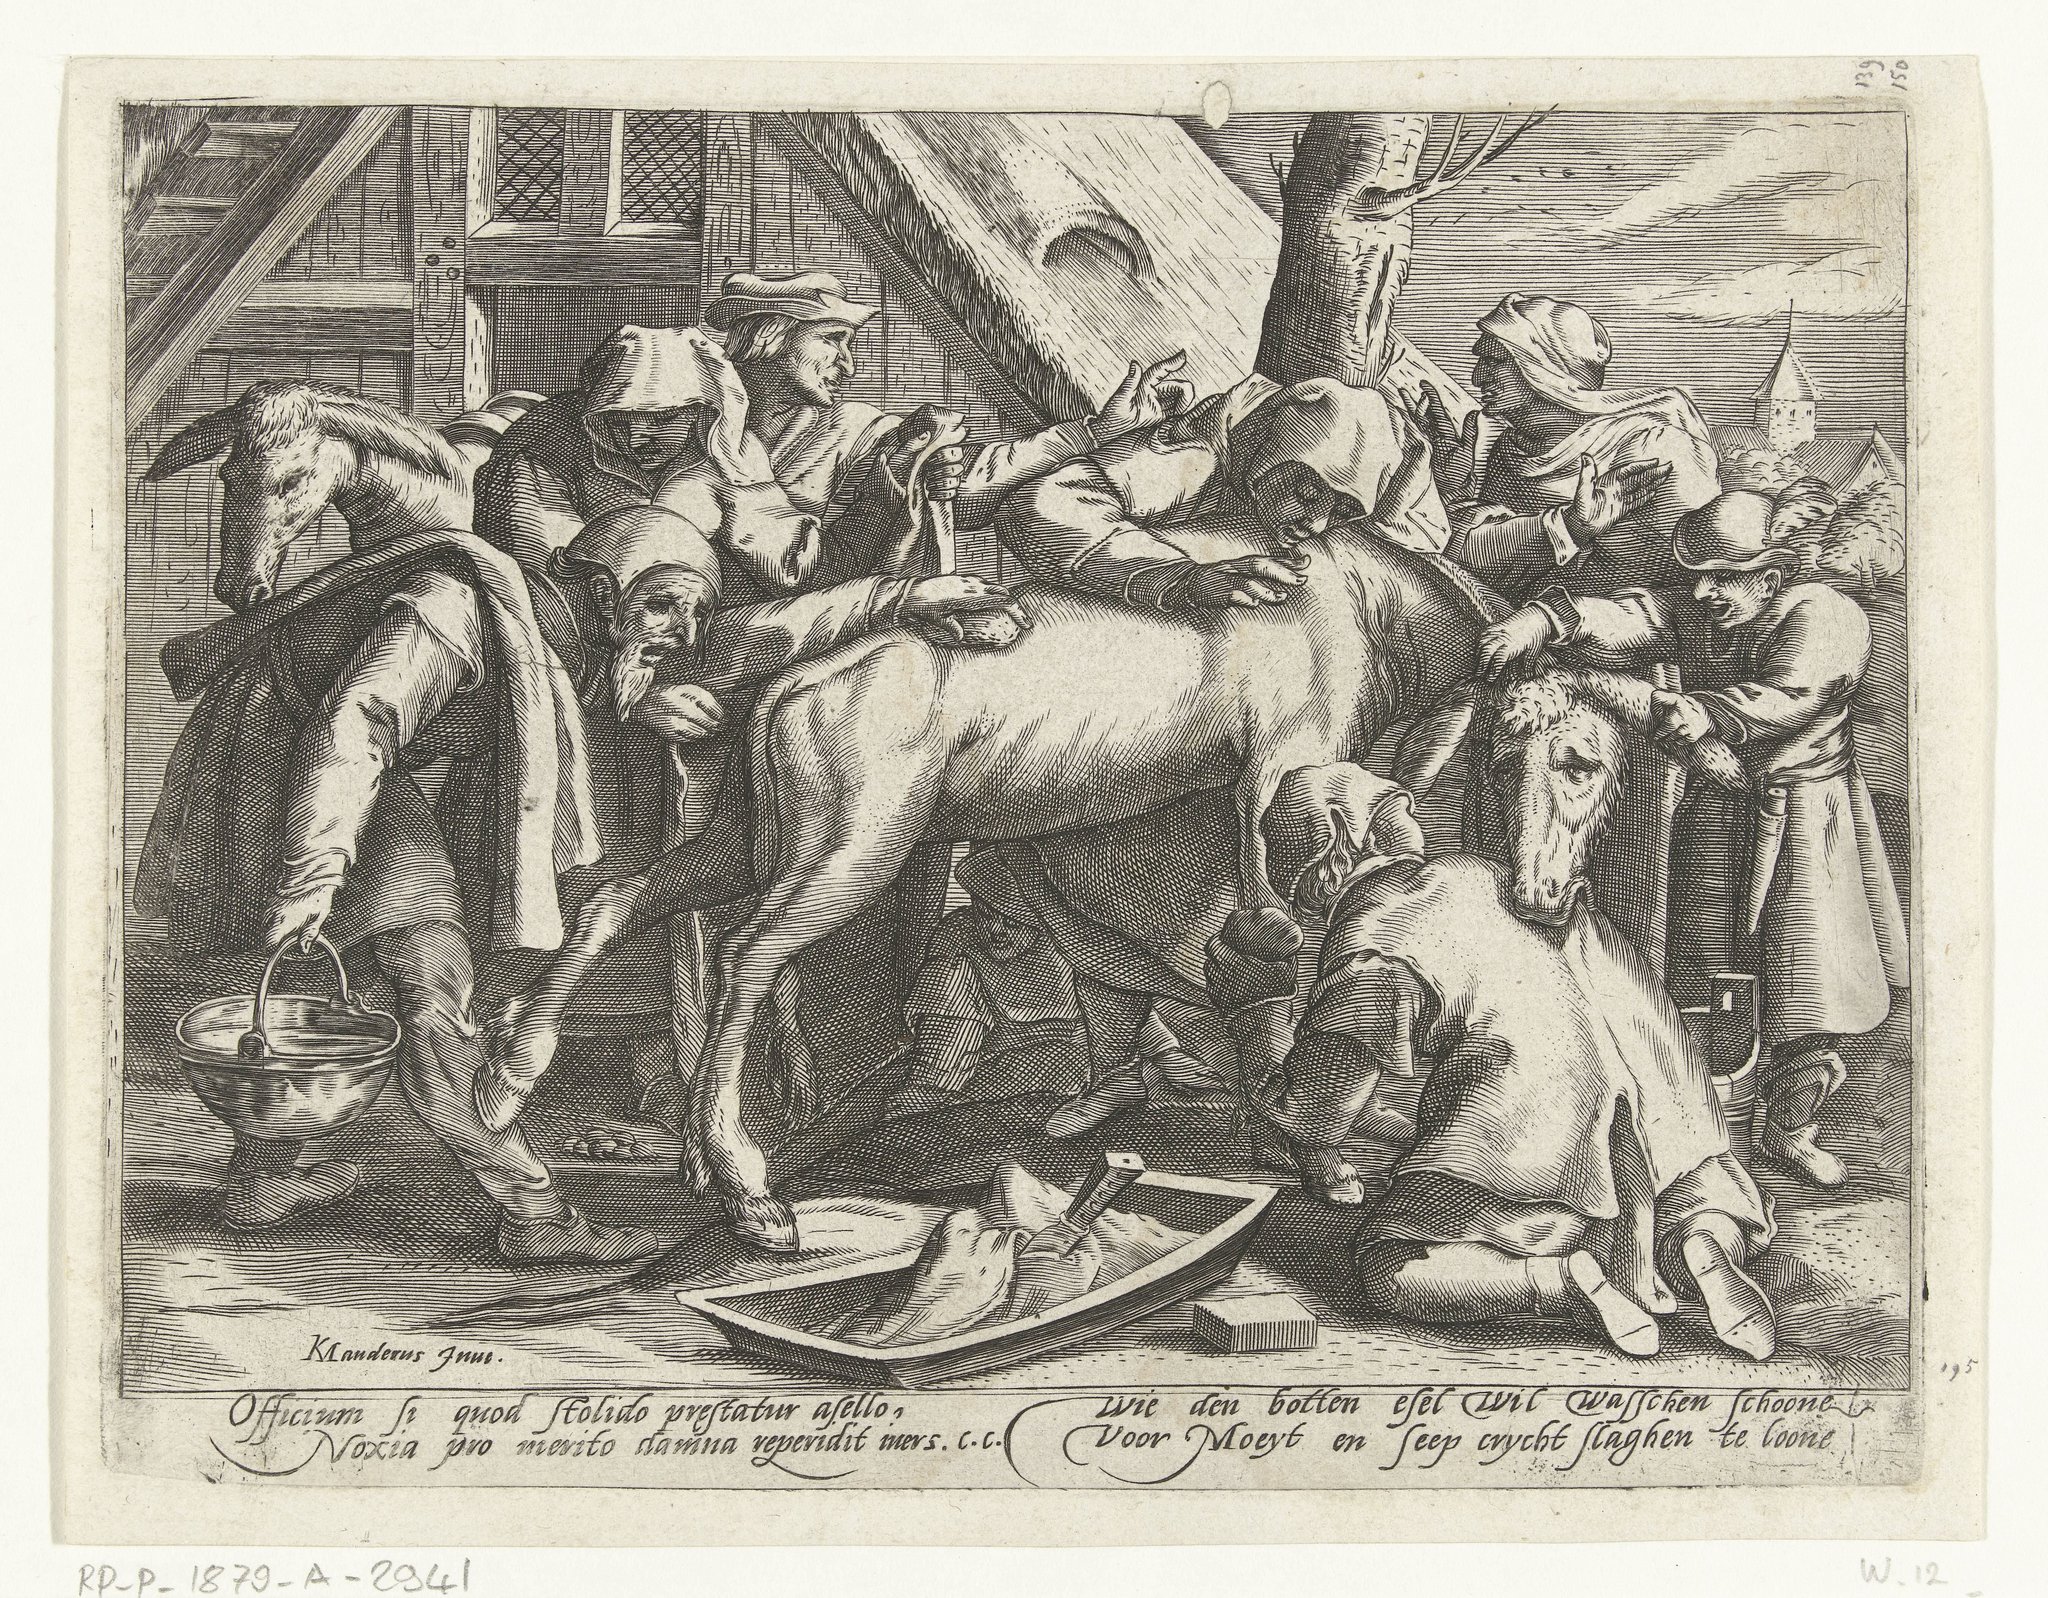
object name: print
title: Het wassen van de ezel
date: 1595-1605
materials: paper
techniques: engraving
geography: haarlem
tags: ass, donkey, proverbs, sayings, etc.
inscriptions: collector's mark: Lugt 2228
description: Een groep van mannen probeert een ezel te wassen. De mannen zijn druk met emmers, zeep en doekjes in de weer. Het wordt hun niet in dank afgenomen. De ezel schopt met zijn poten en bijt een van de mannen in de rug. In de ondermarge een vers in het Latijn, ondertekend C.C., en een Nederlands spreekwoord.